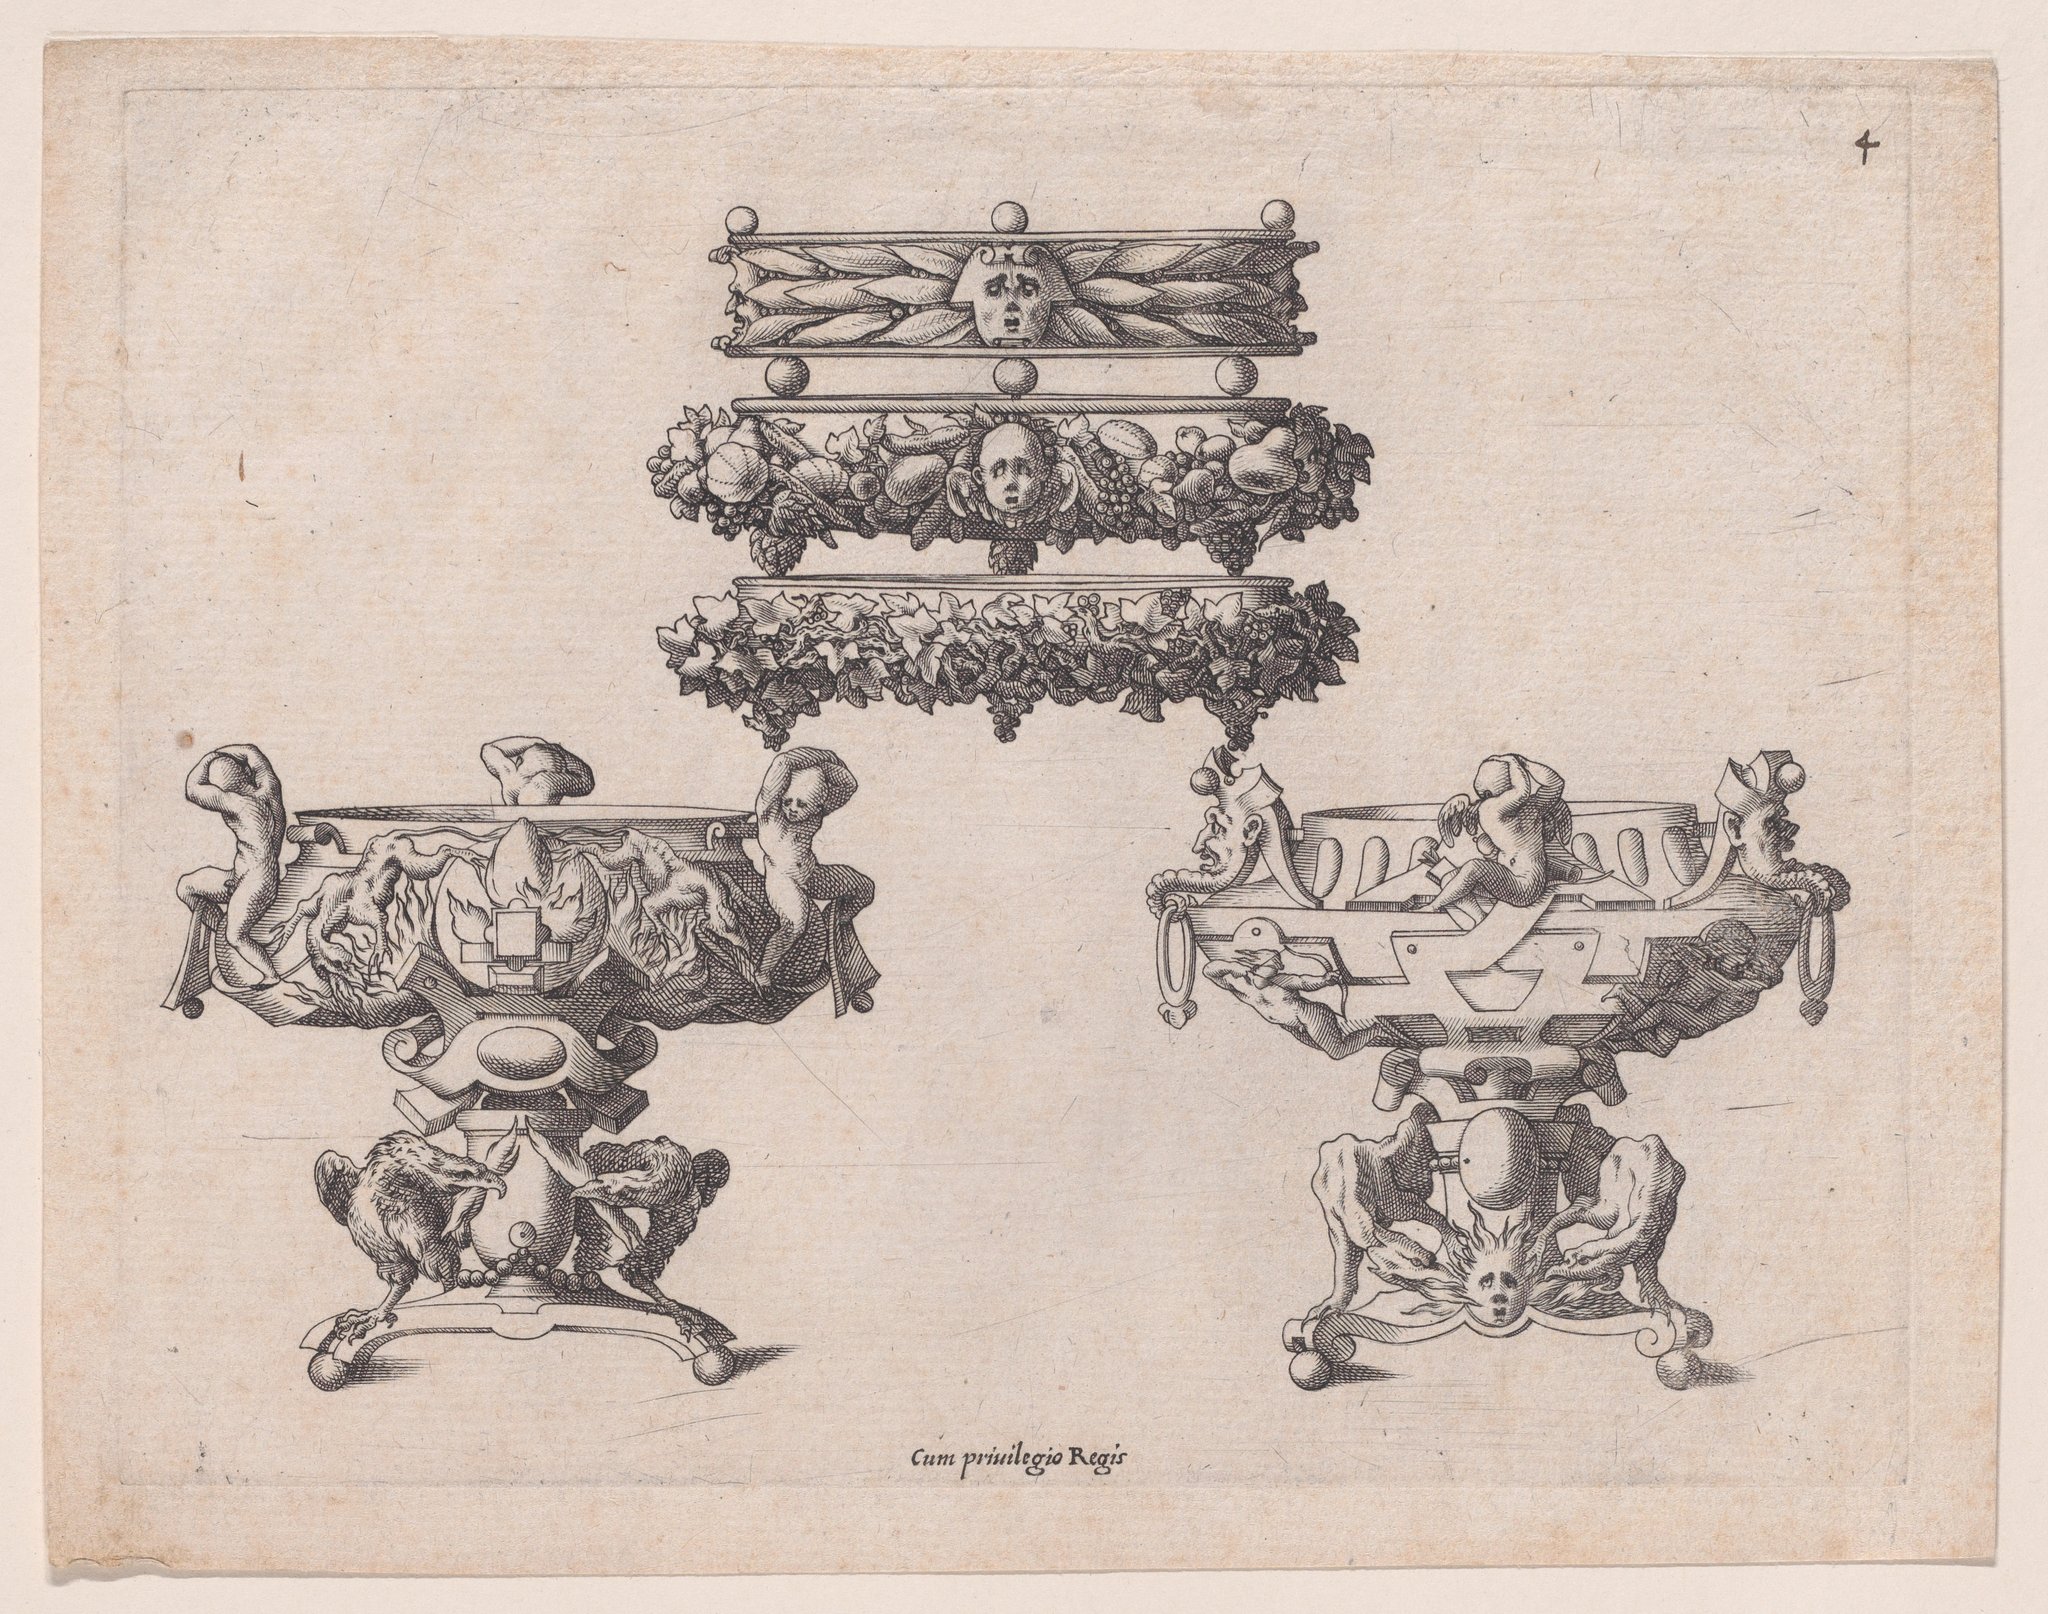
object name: print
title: Two Braziers and Three Salvers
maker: rené boyvin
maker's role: artist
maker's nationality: french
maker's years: 1525-1598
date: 1525-1600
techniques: engraving